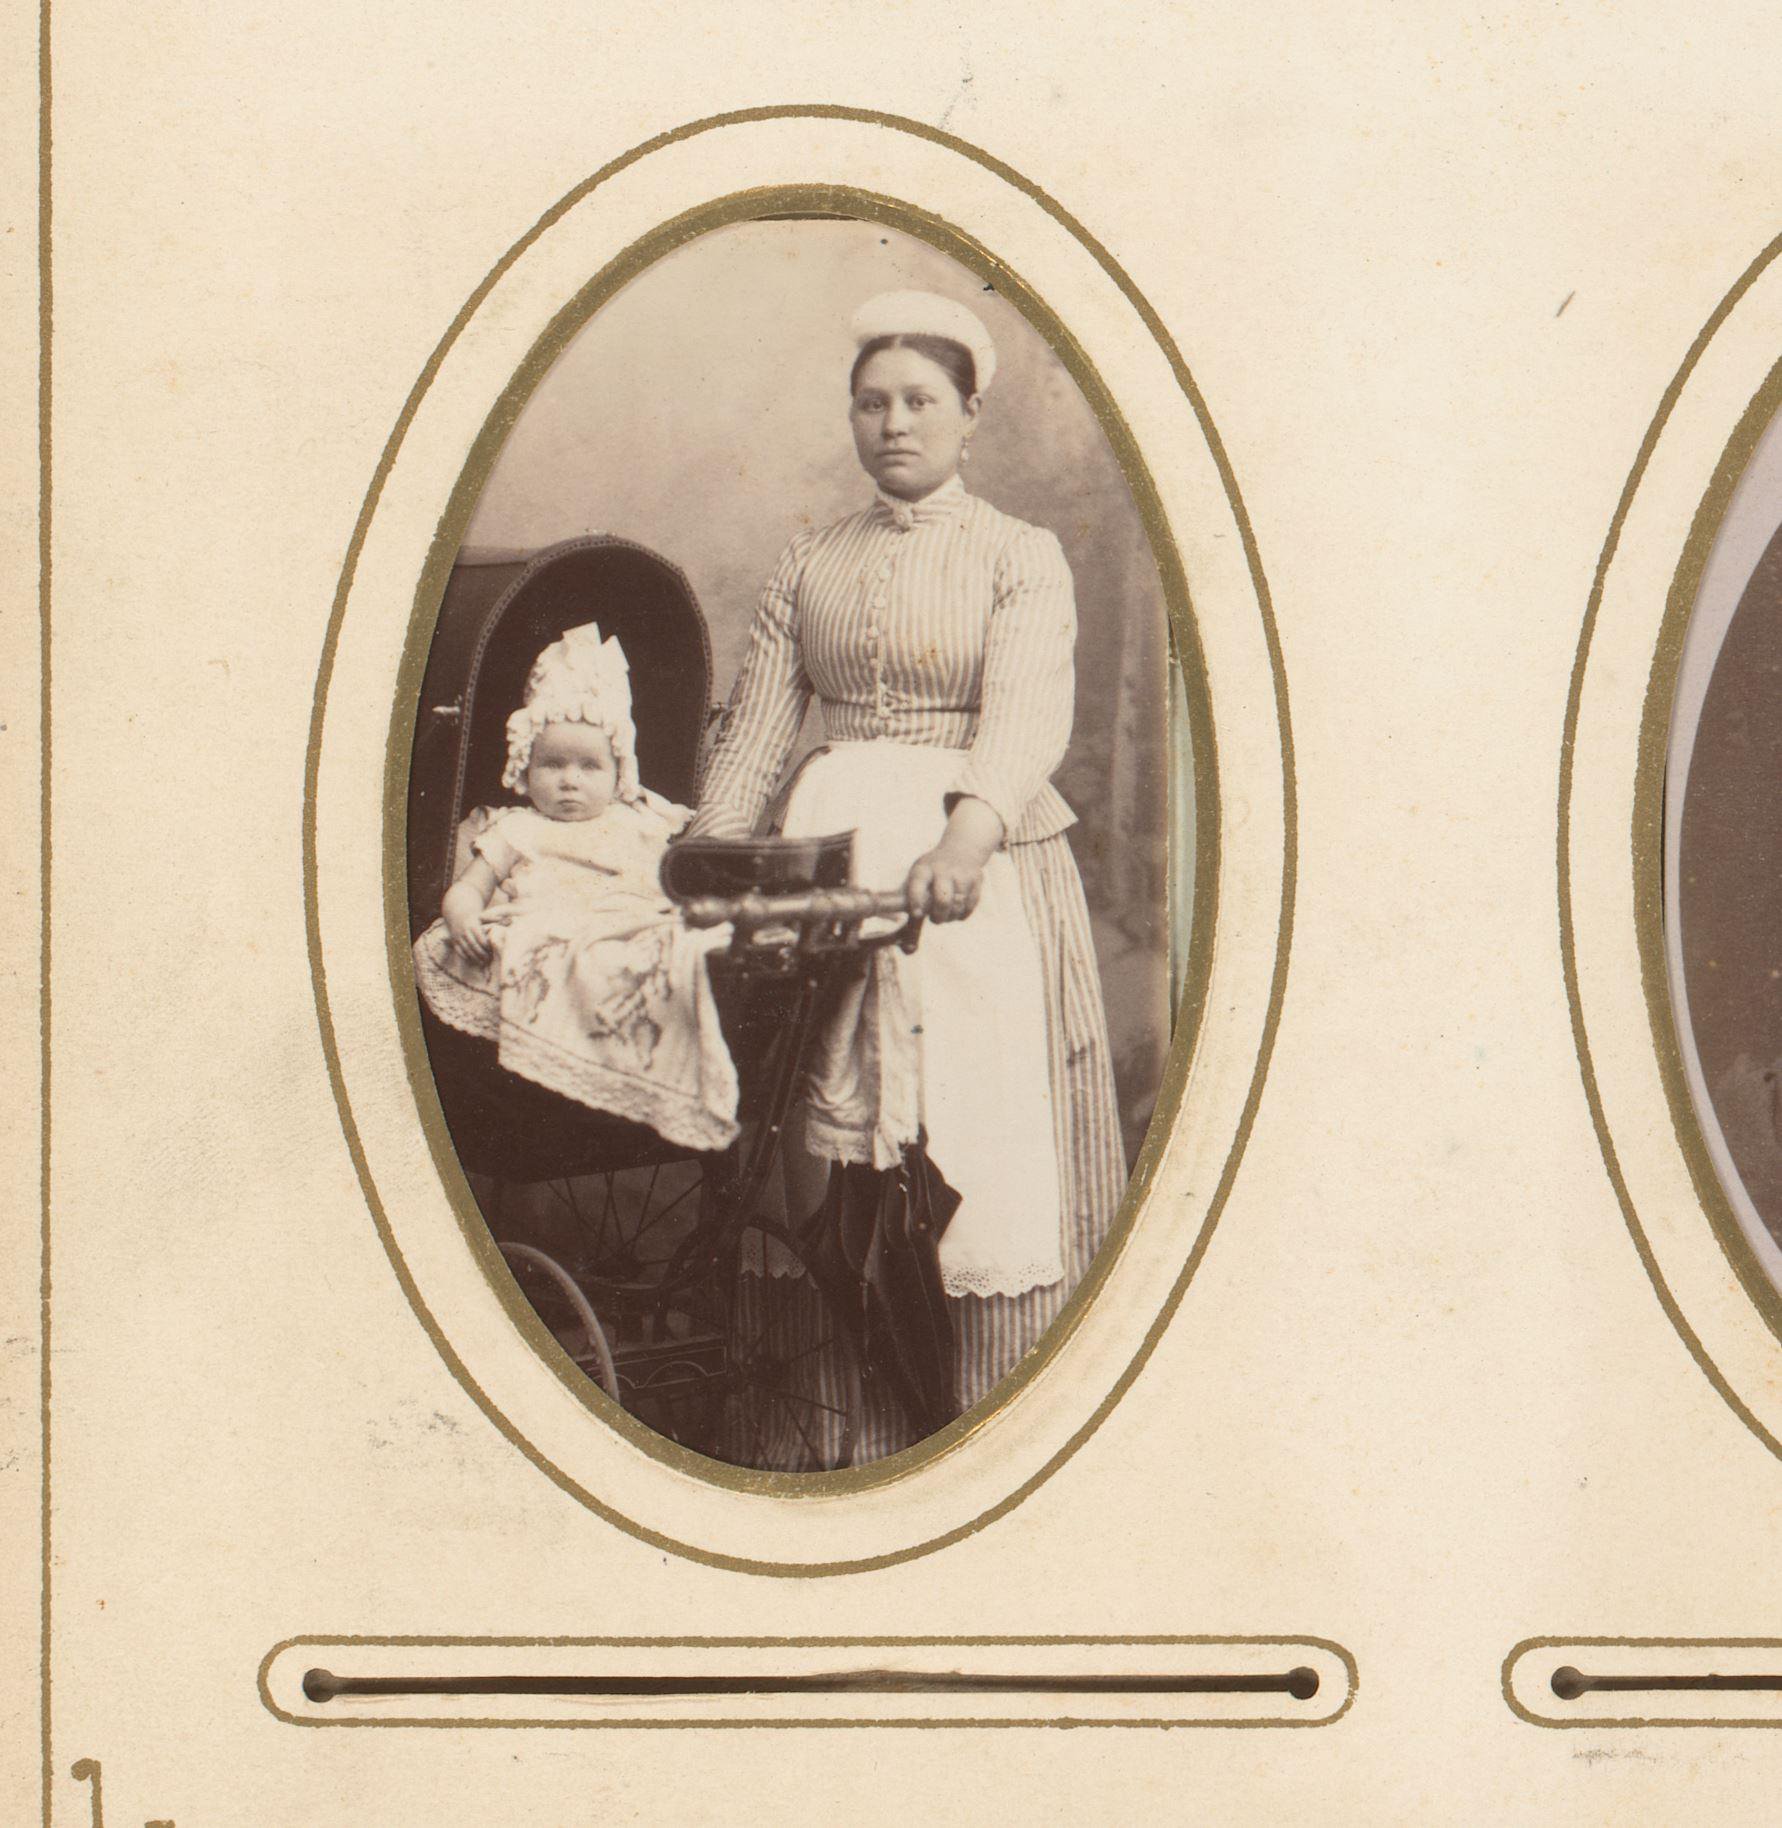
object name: photograph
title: Portret van een vrouw, staand bij een kinderwagen met daarin een baby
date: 1882-1890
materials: cardboard, photographic support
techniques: albumen print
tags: baby-carriage, pram, perambulator, historical persons - bb - woman, infant, baby ~ the ages of man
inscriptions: inscription: ‘Photographische Inrichting/ van/ Jacques Chits/ Haarlem/ Nassaustraat/ No. 14./ Amsterdam/ Plantage/ Kerklaan No. 15/ over de Koningskroon./ De plaat blijft ter nabestelling bewaard.’